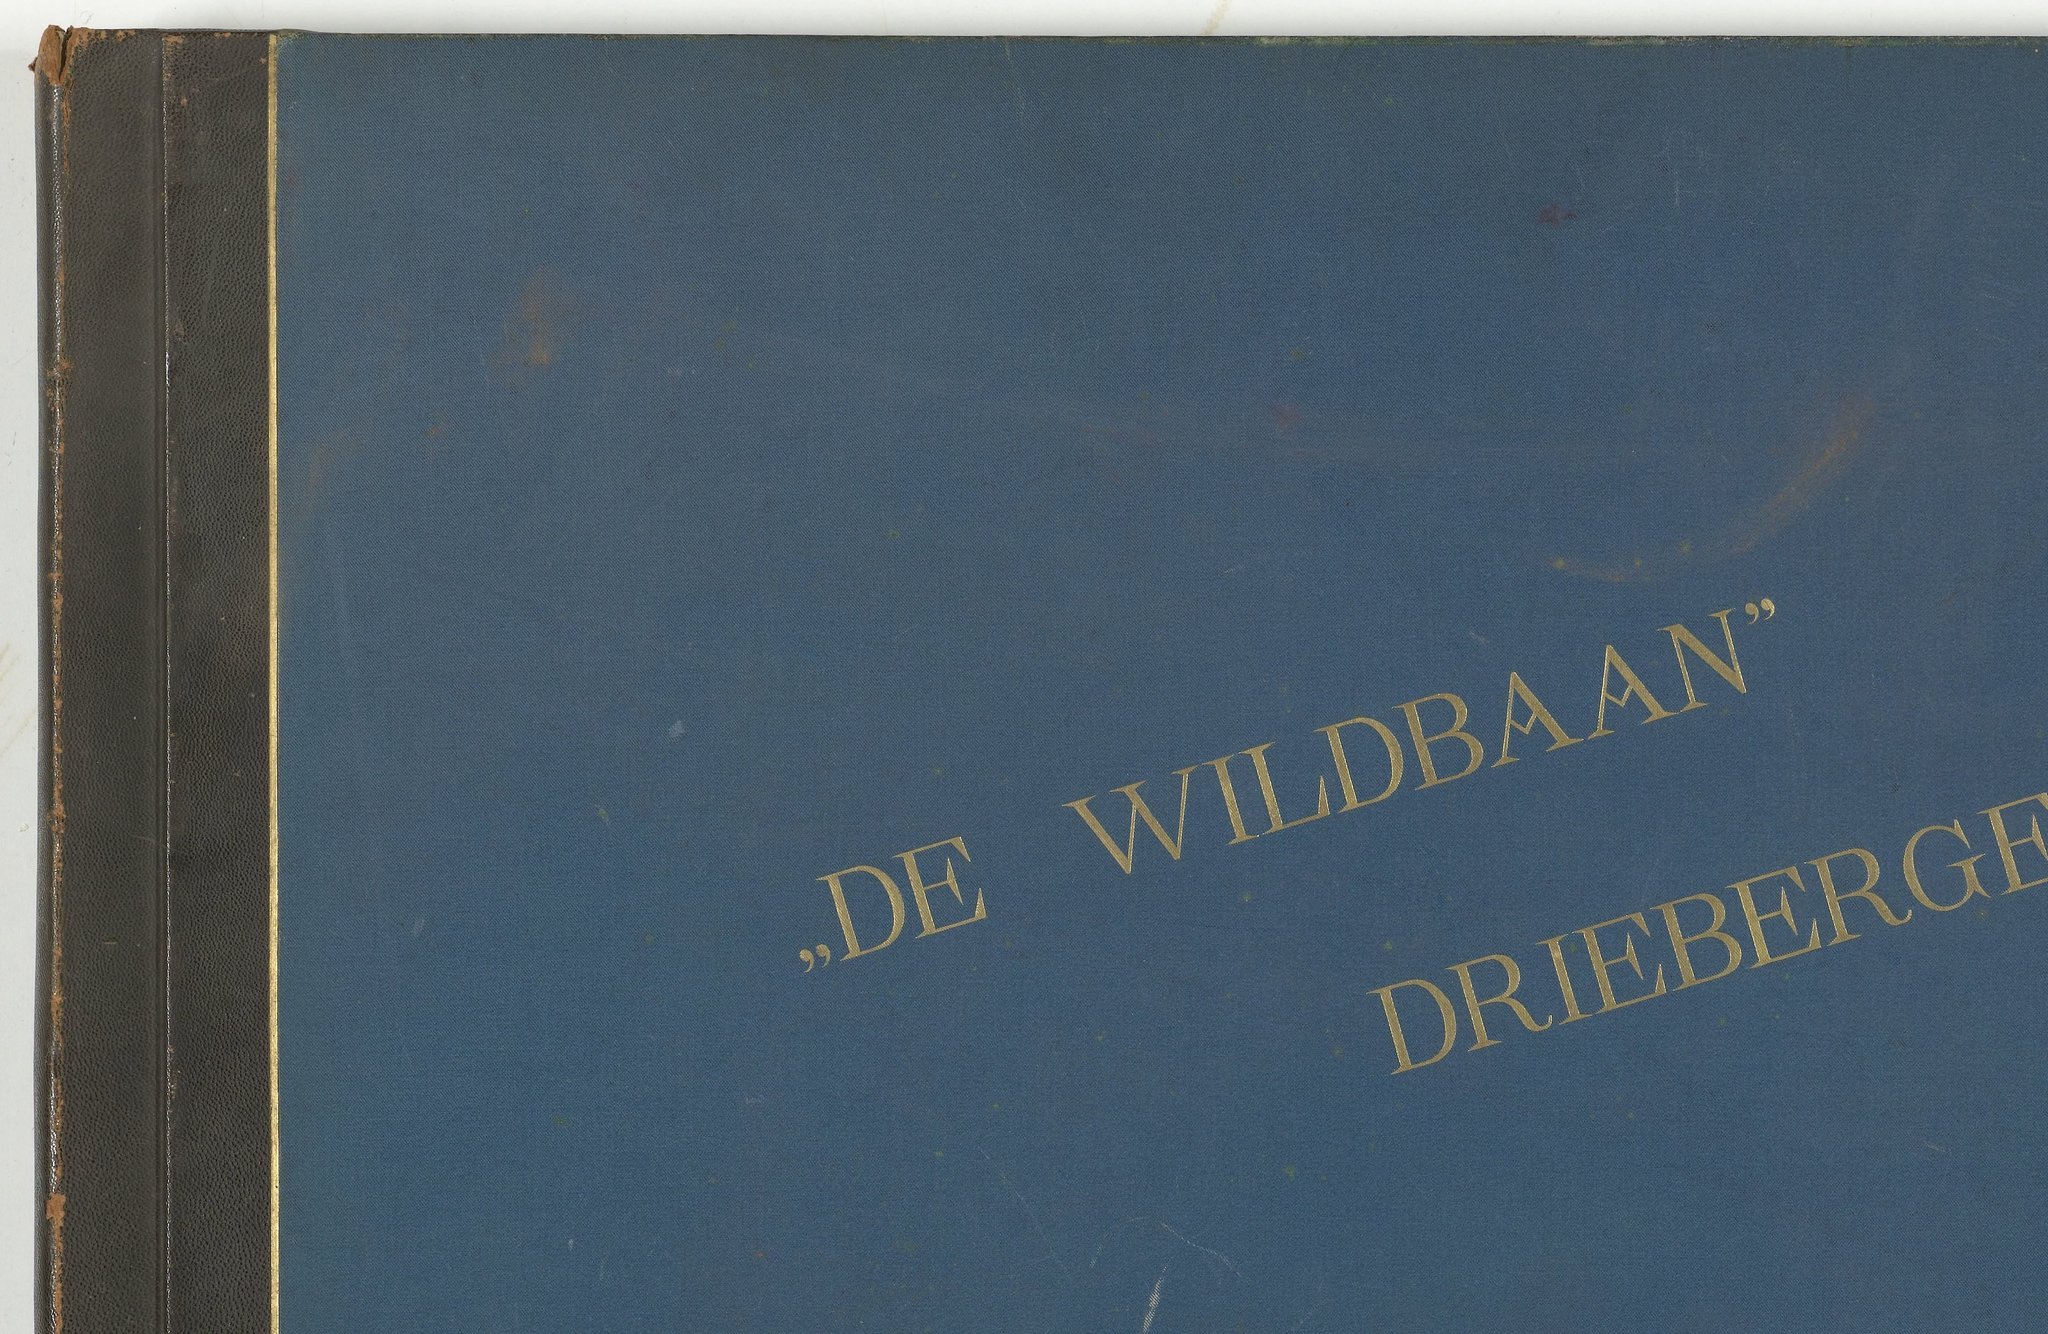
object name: photograph album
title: De Wildbaan, Driebergen, 1903-1907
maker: henry pauw van wieldrecht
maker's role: fotograaf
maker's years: 1863-1912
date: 1903-1907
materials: paper, photographic support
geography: netherlands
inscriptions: title: ‘"DE WILDBAAN" / DRIEBERGEN. / 1903-1907’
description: Fotoalbum met 37 foto's gemaakt in en rond het landhuis De Wildbaan, Driebergen, het woonhuis van de fotograaf, met opnamen van ex- en interieur, het park, werklieden, jachttrofeeën en kamer waarin hij zijn foto's afwerkte.